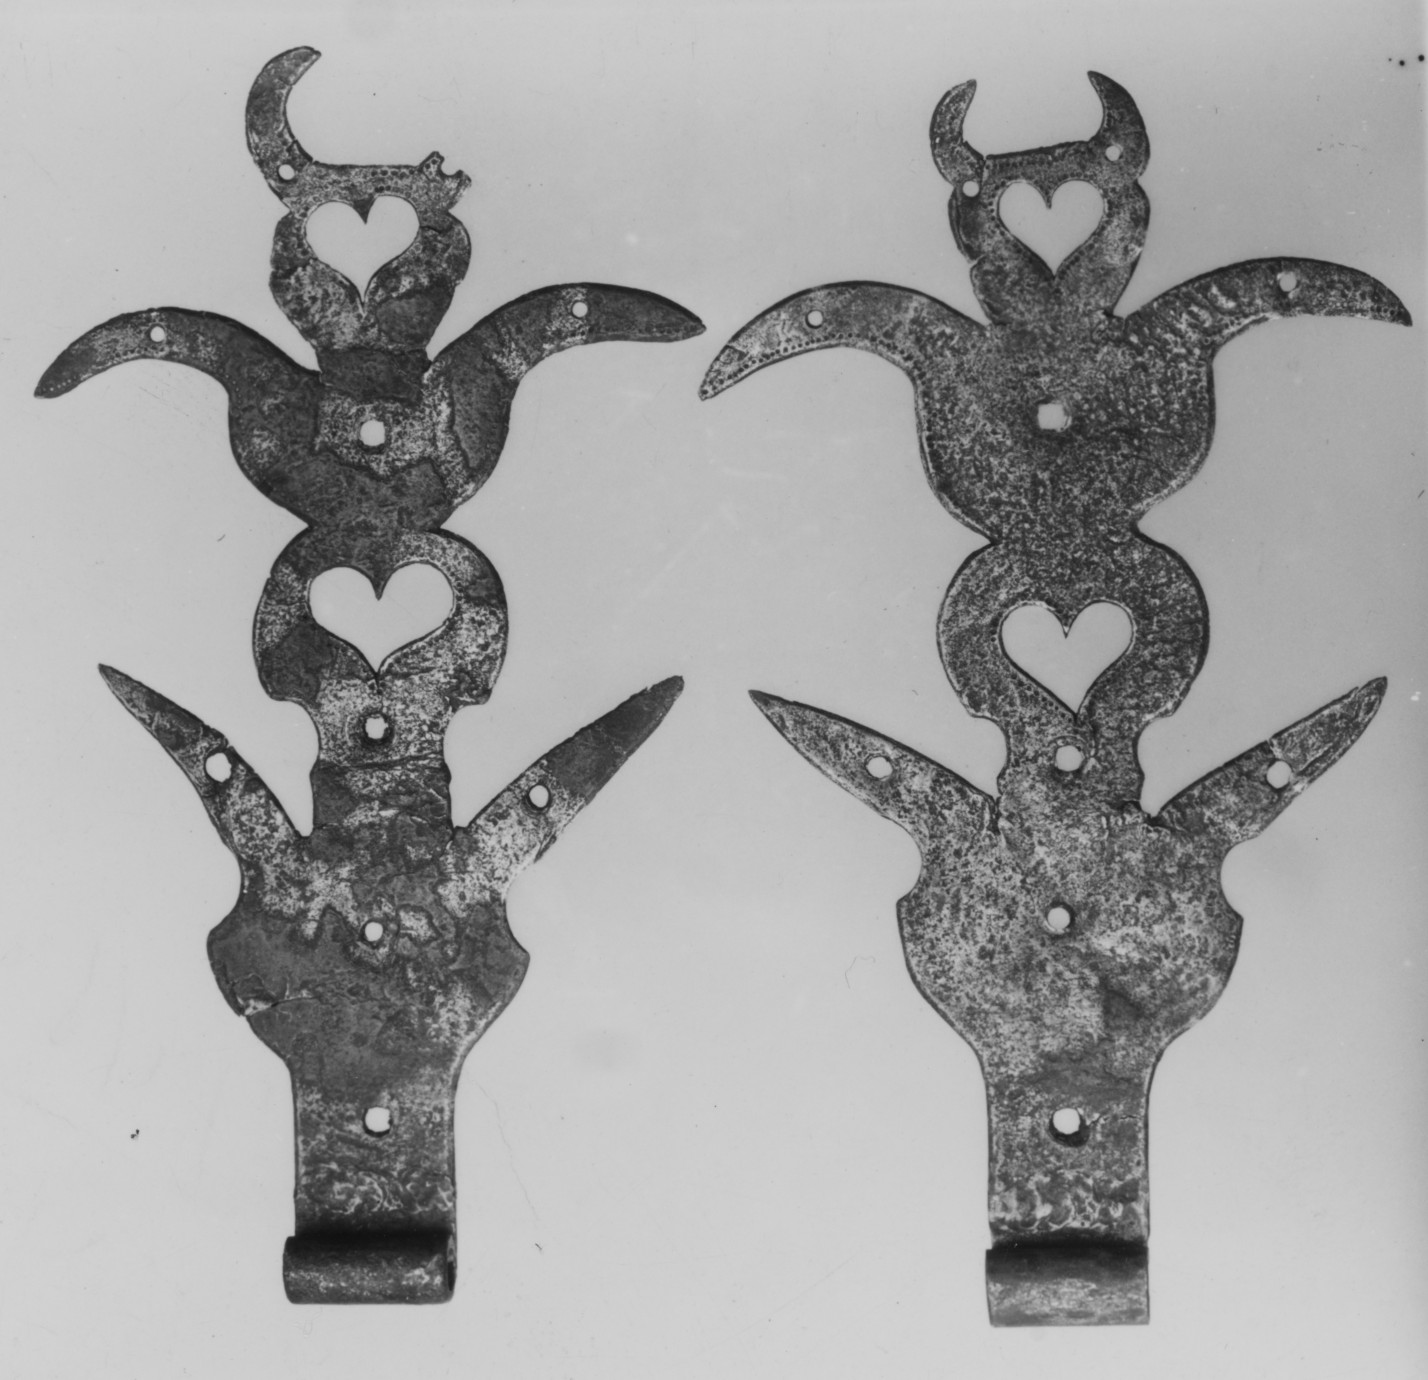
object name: hinge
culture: american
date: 1700-1800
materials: iron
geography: united states